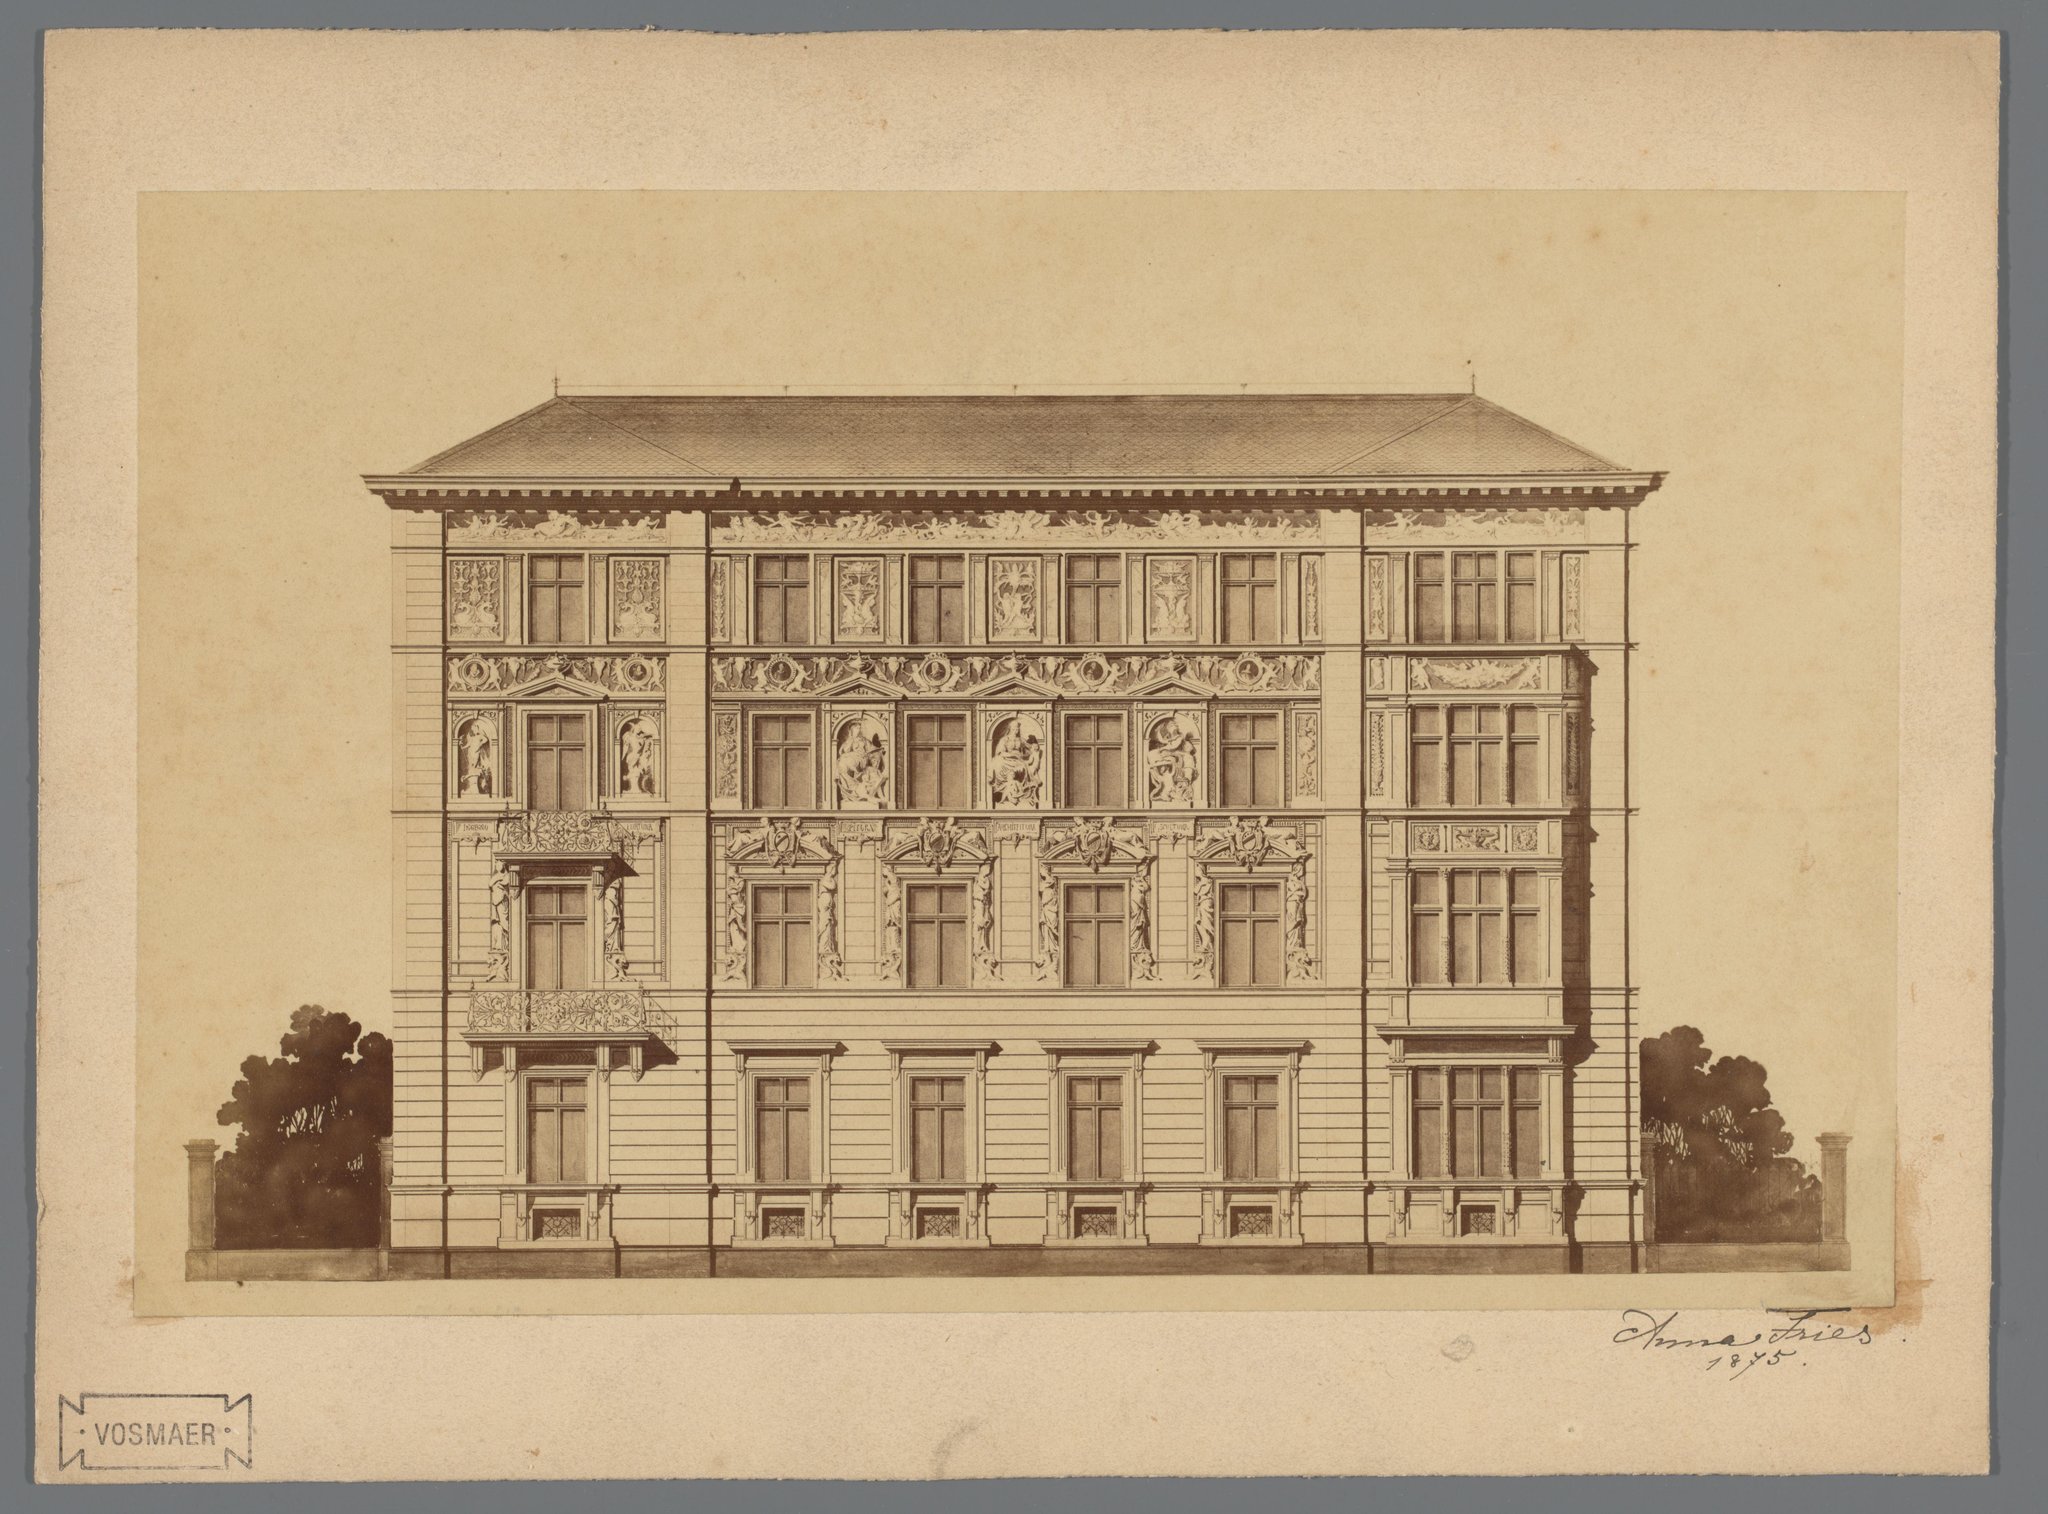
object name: reproduction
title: Fotoreproductie van een tekening van een villa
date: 1875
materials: cardboard, paper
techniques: albumen print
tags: drawing, sketch, italy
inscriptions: collector's mark: ‘VOSMAER’, inscription: ‘Anna Fries/ 1875’